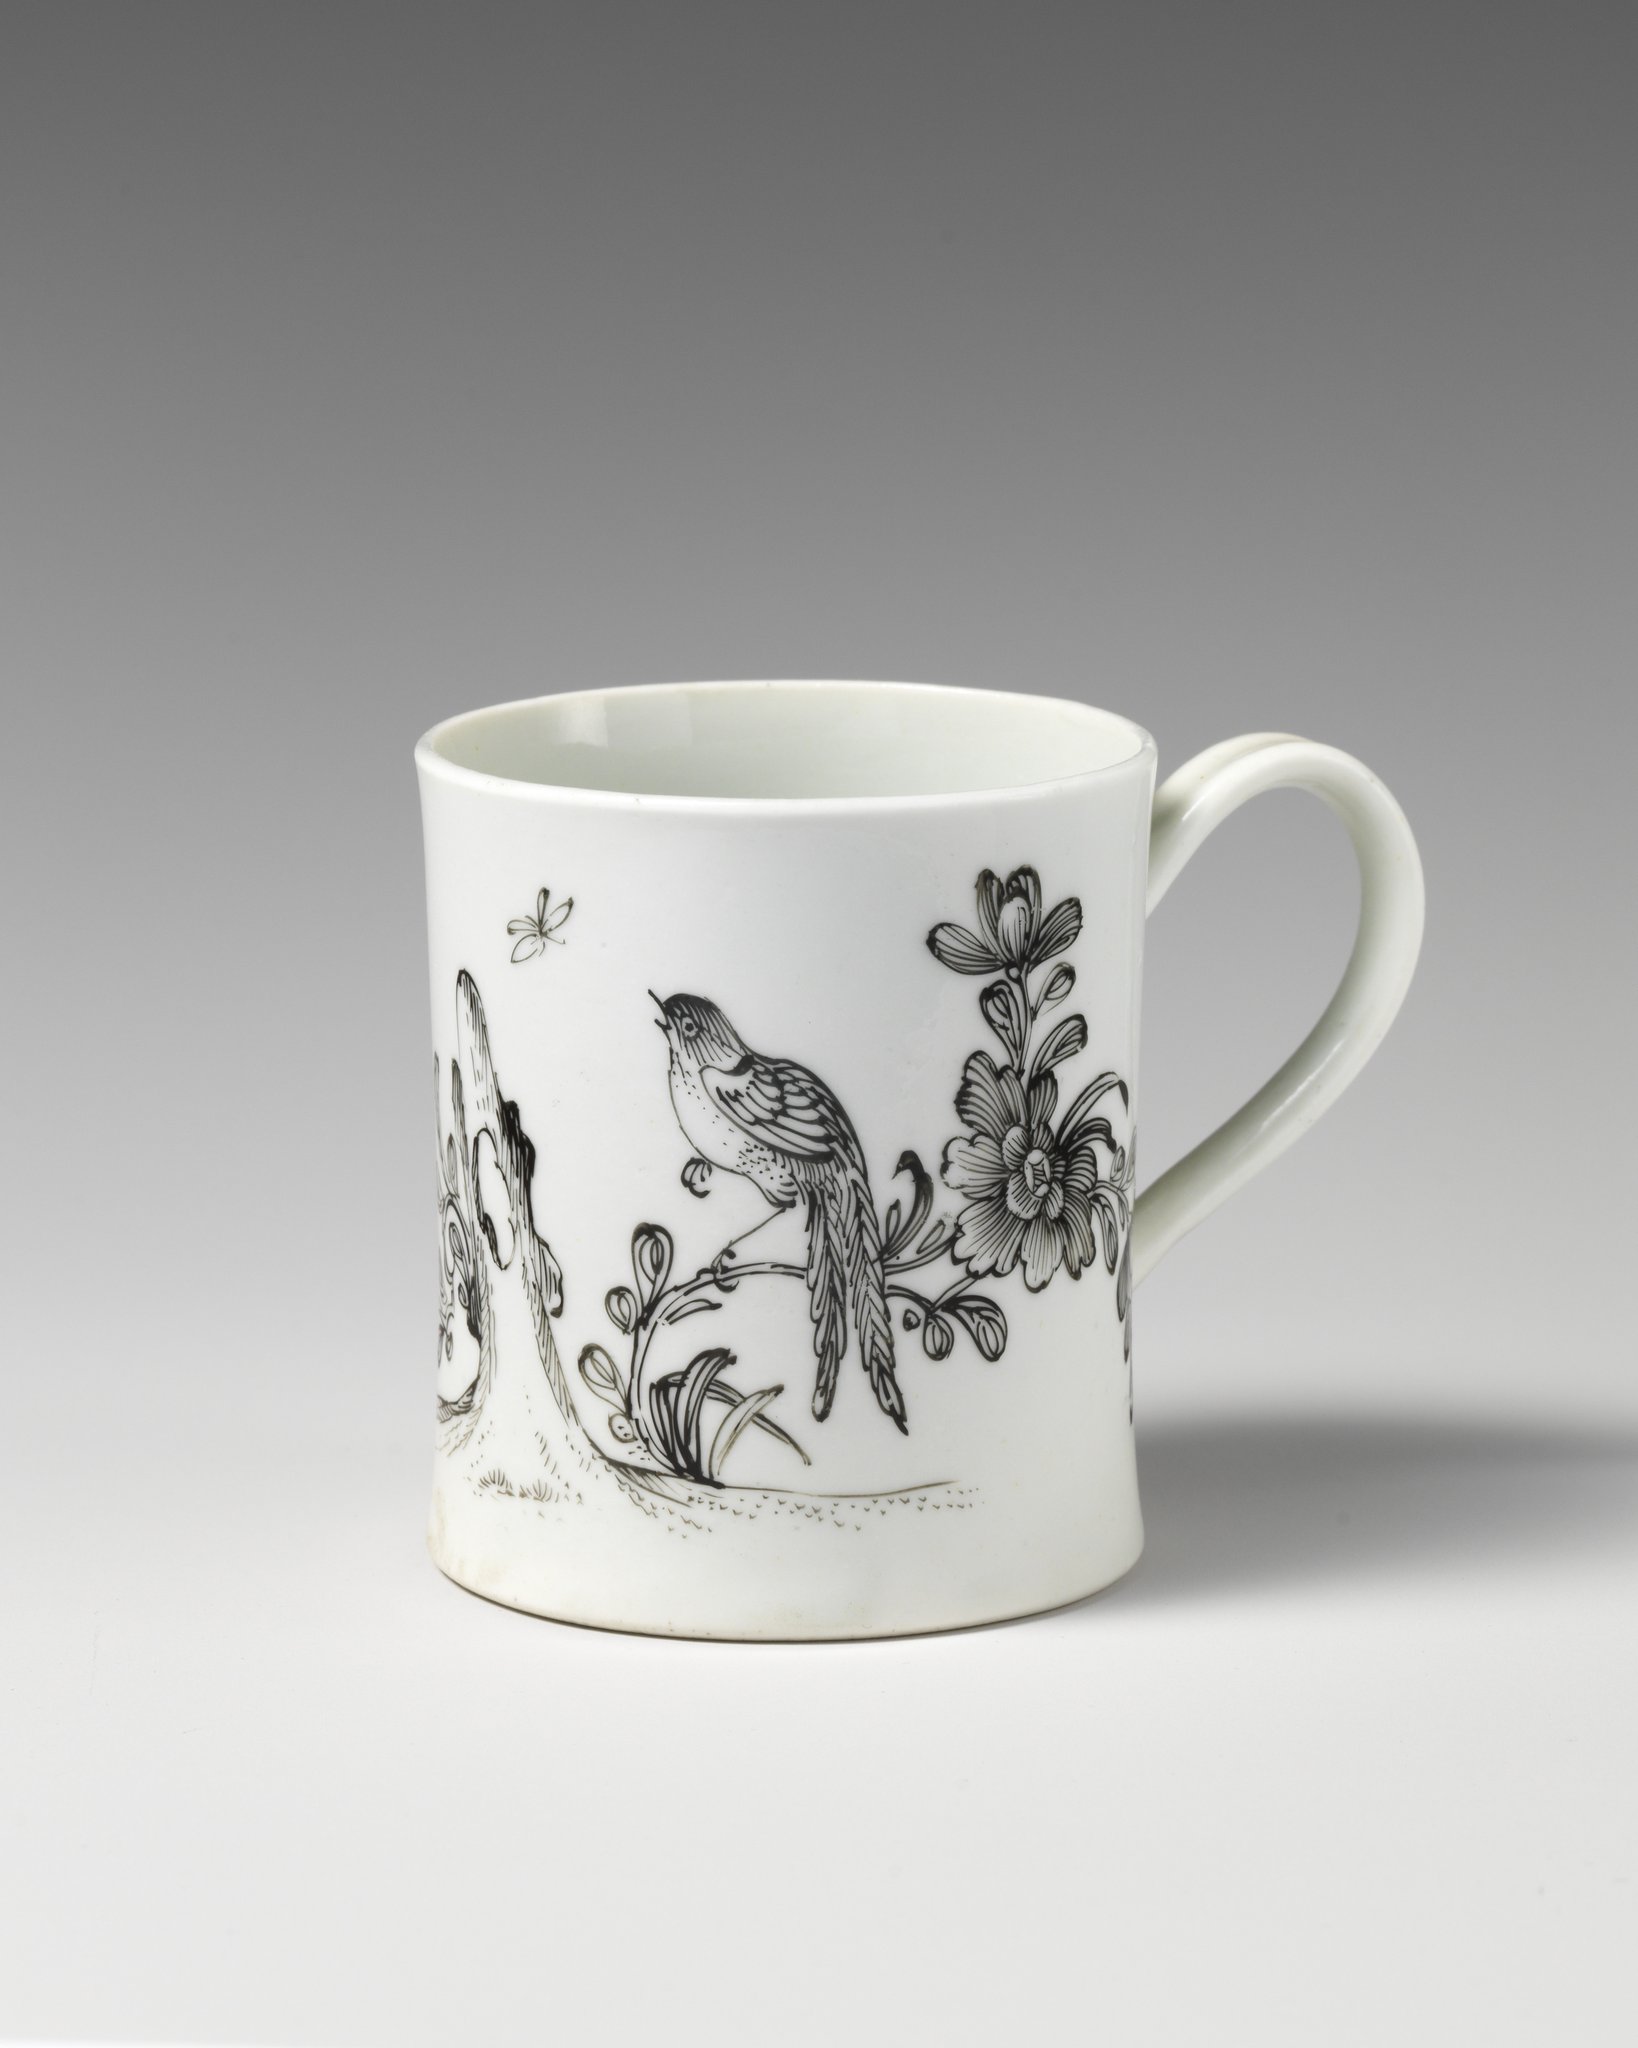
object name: mug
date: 1701-1800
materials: soft paste porcelain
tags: birds,butterflies,flowers